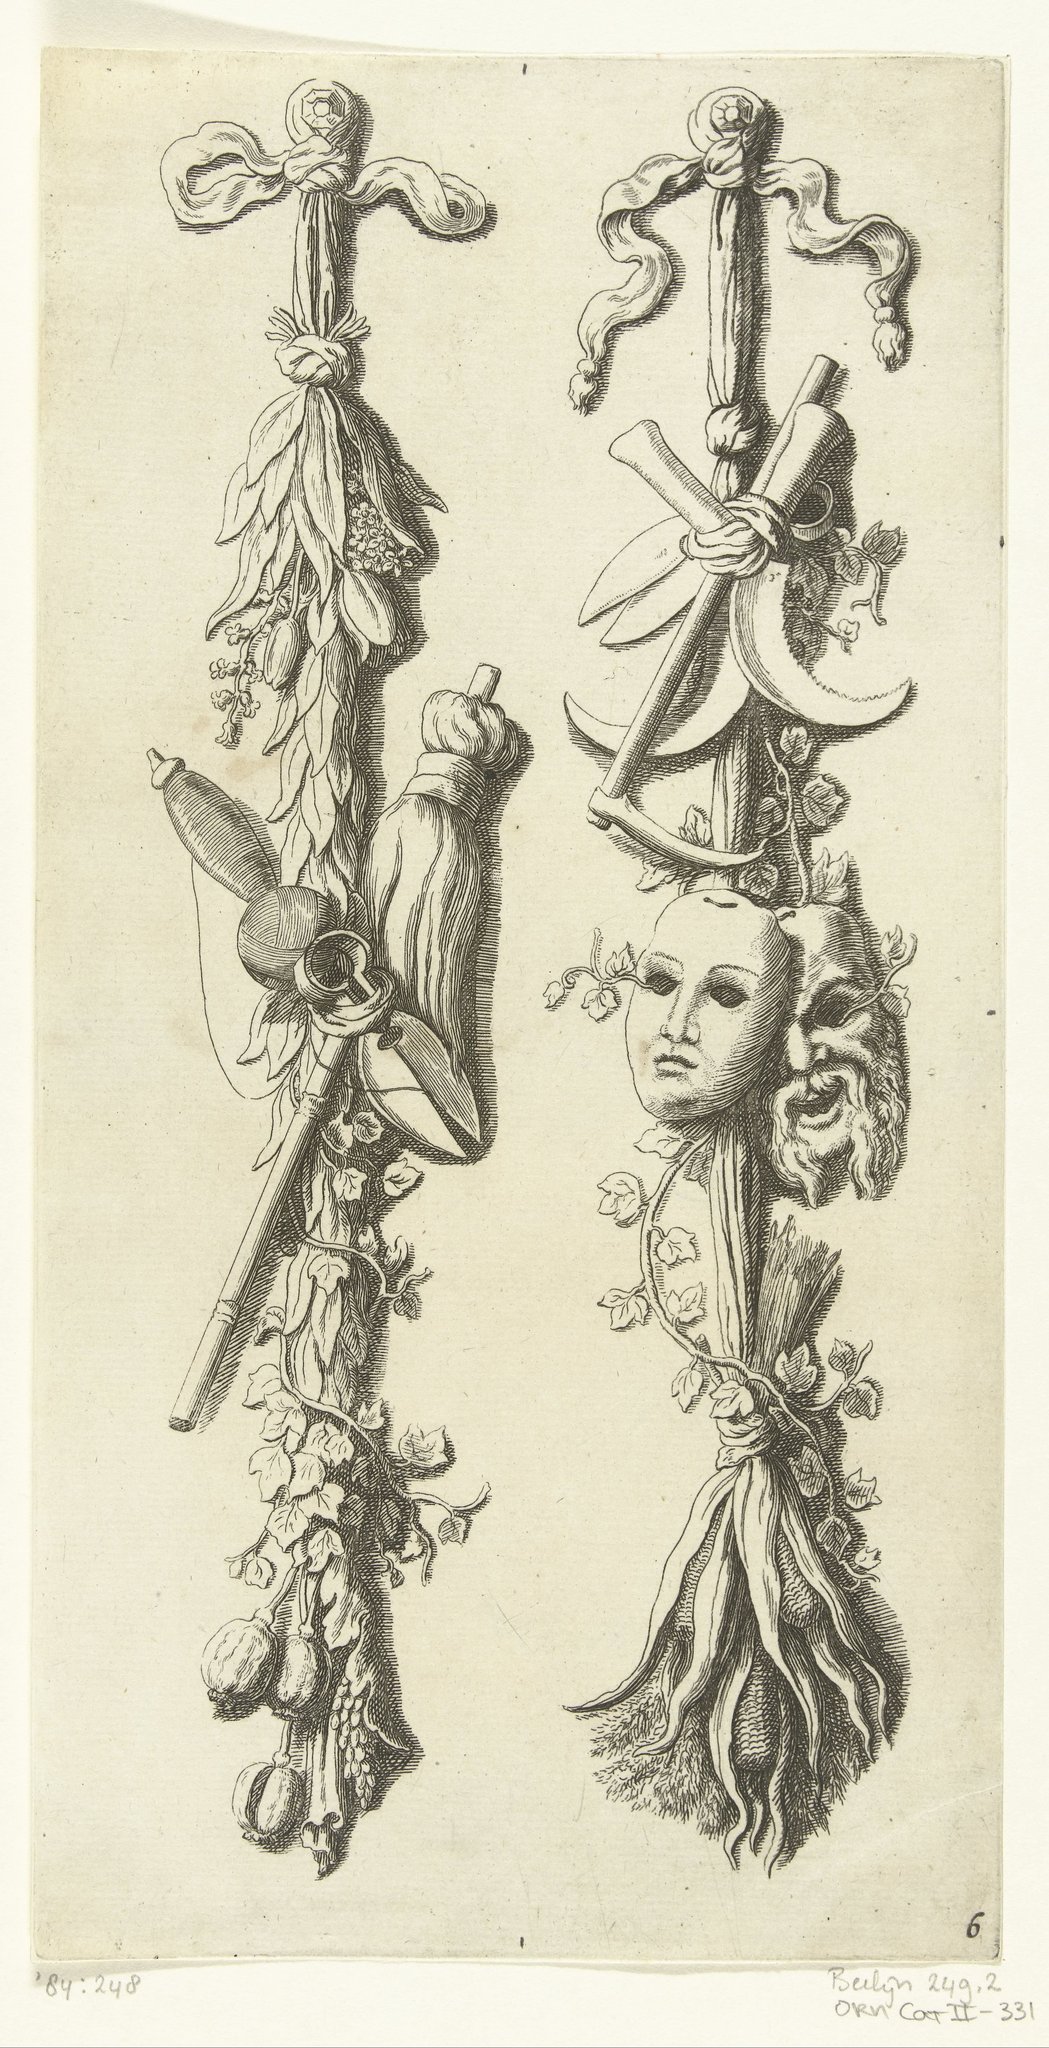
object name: print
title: Pilaster Festonnen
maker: Anonymous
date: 1665-1700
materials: paper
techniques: etching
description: Aan de trofee links hangt een spinklos, aan de trofee rechts hangen twee maskers. Tegenzijdige kopie naar prenten uitgegeven door Hubertus Quellinus en prenten uitgegeven door Johannes de Ram. Festoenen in het stadhuis van Amsterdam.